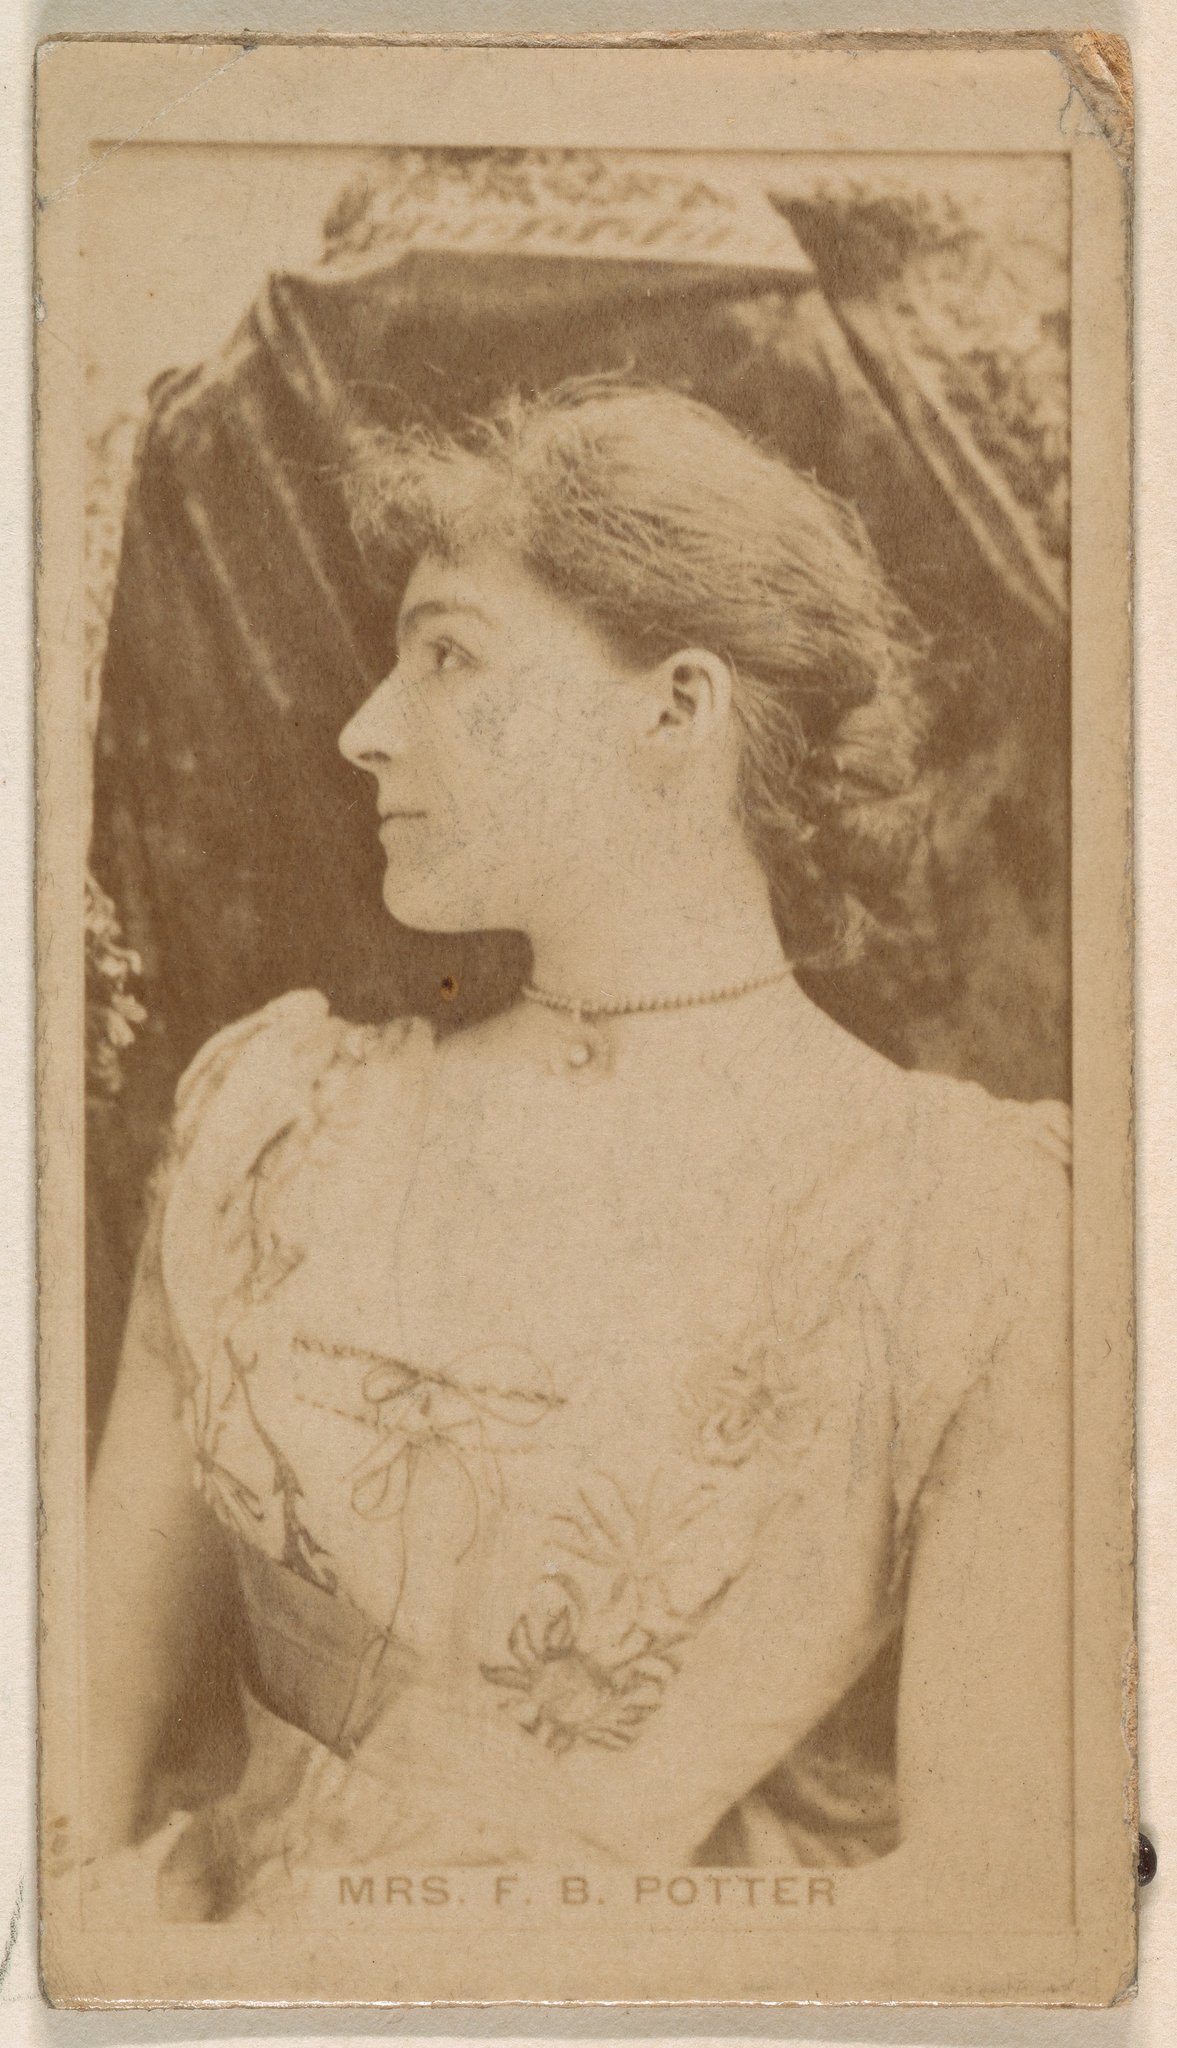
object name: photograph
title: Mrs. James Brown Potter, from the Actresses series (N245) issued by Kinney Brothers to promote Sweet Caporal Cigarettes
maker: kinney brothers tobacco company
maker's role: publisher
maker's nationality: american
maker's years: 1869-2011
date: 1890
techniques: albumen silver print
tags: women,actresses